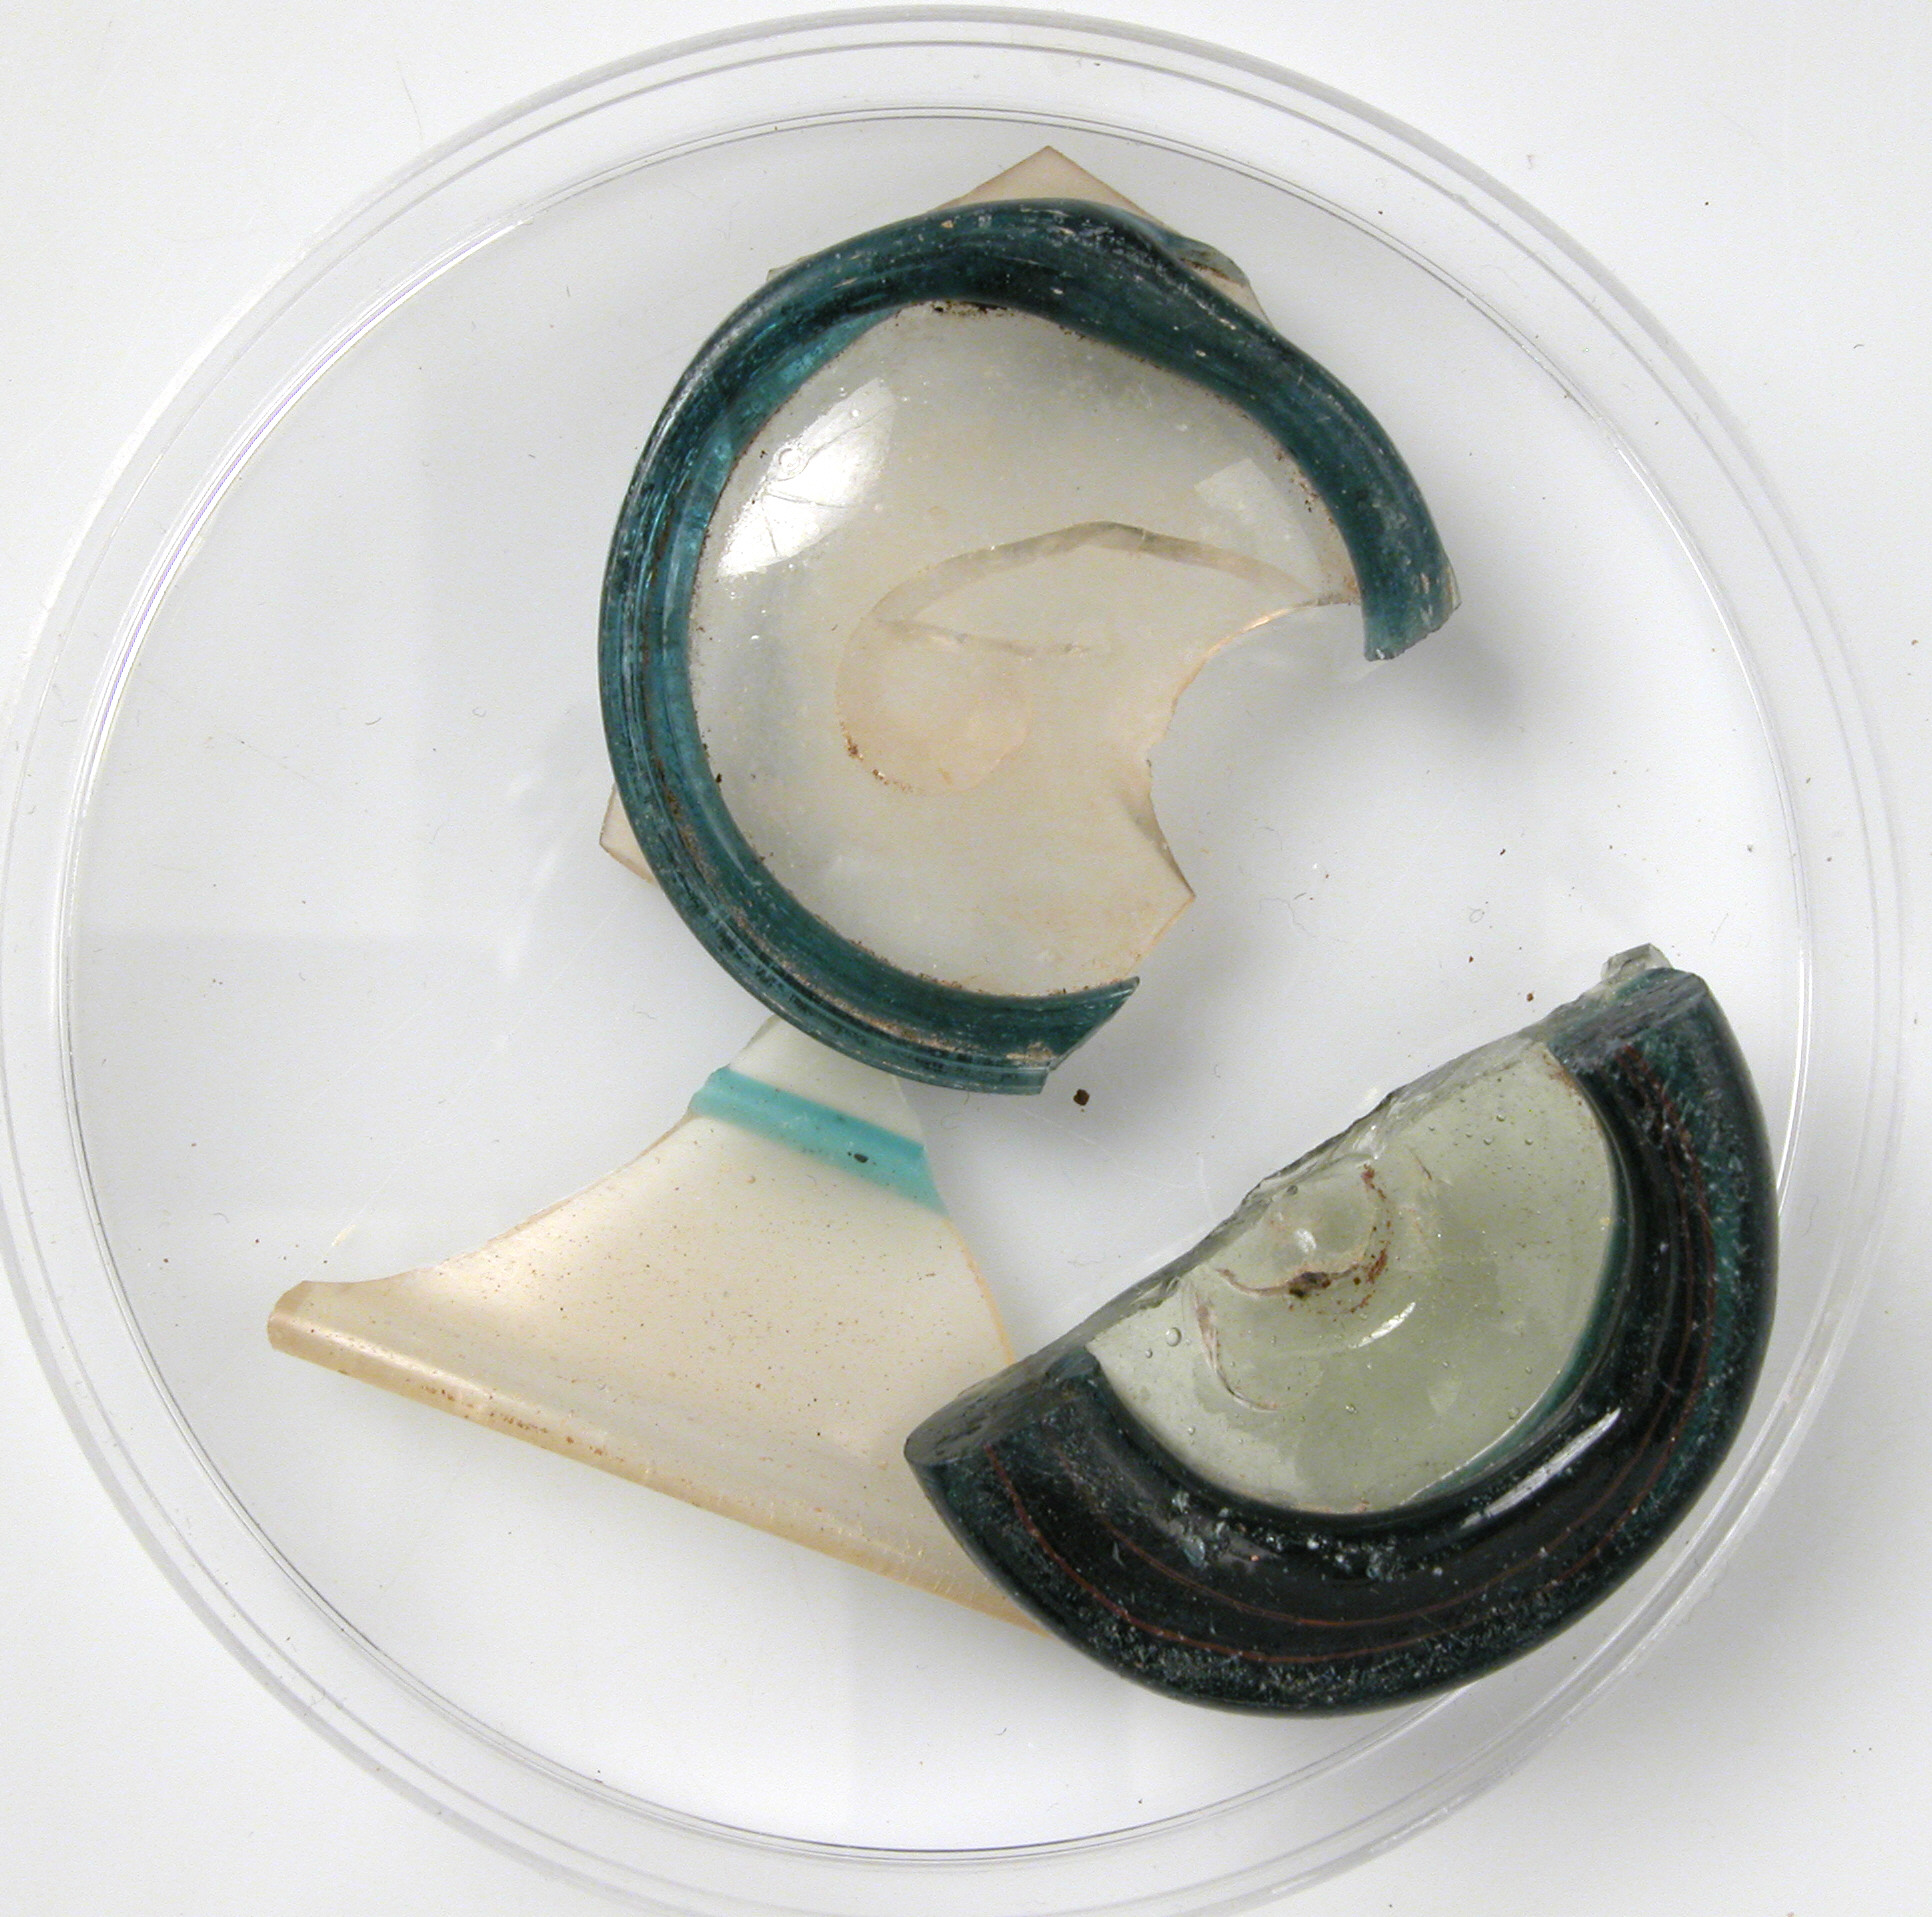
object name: fragment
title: Glass Fragments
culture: coptic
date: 301-700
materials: glass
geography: egypt